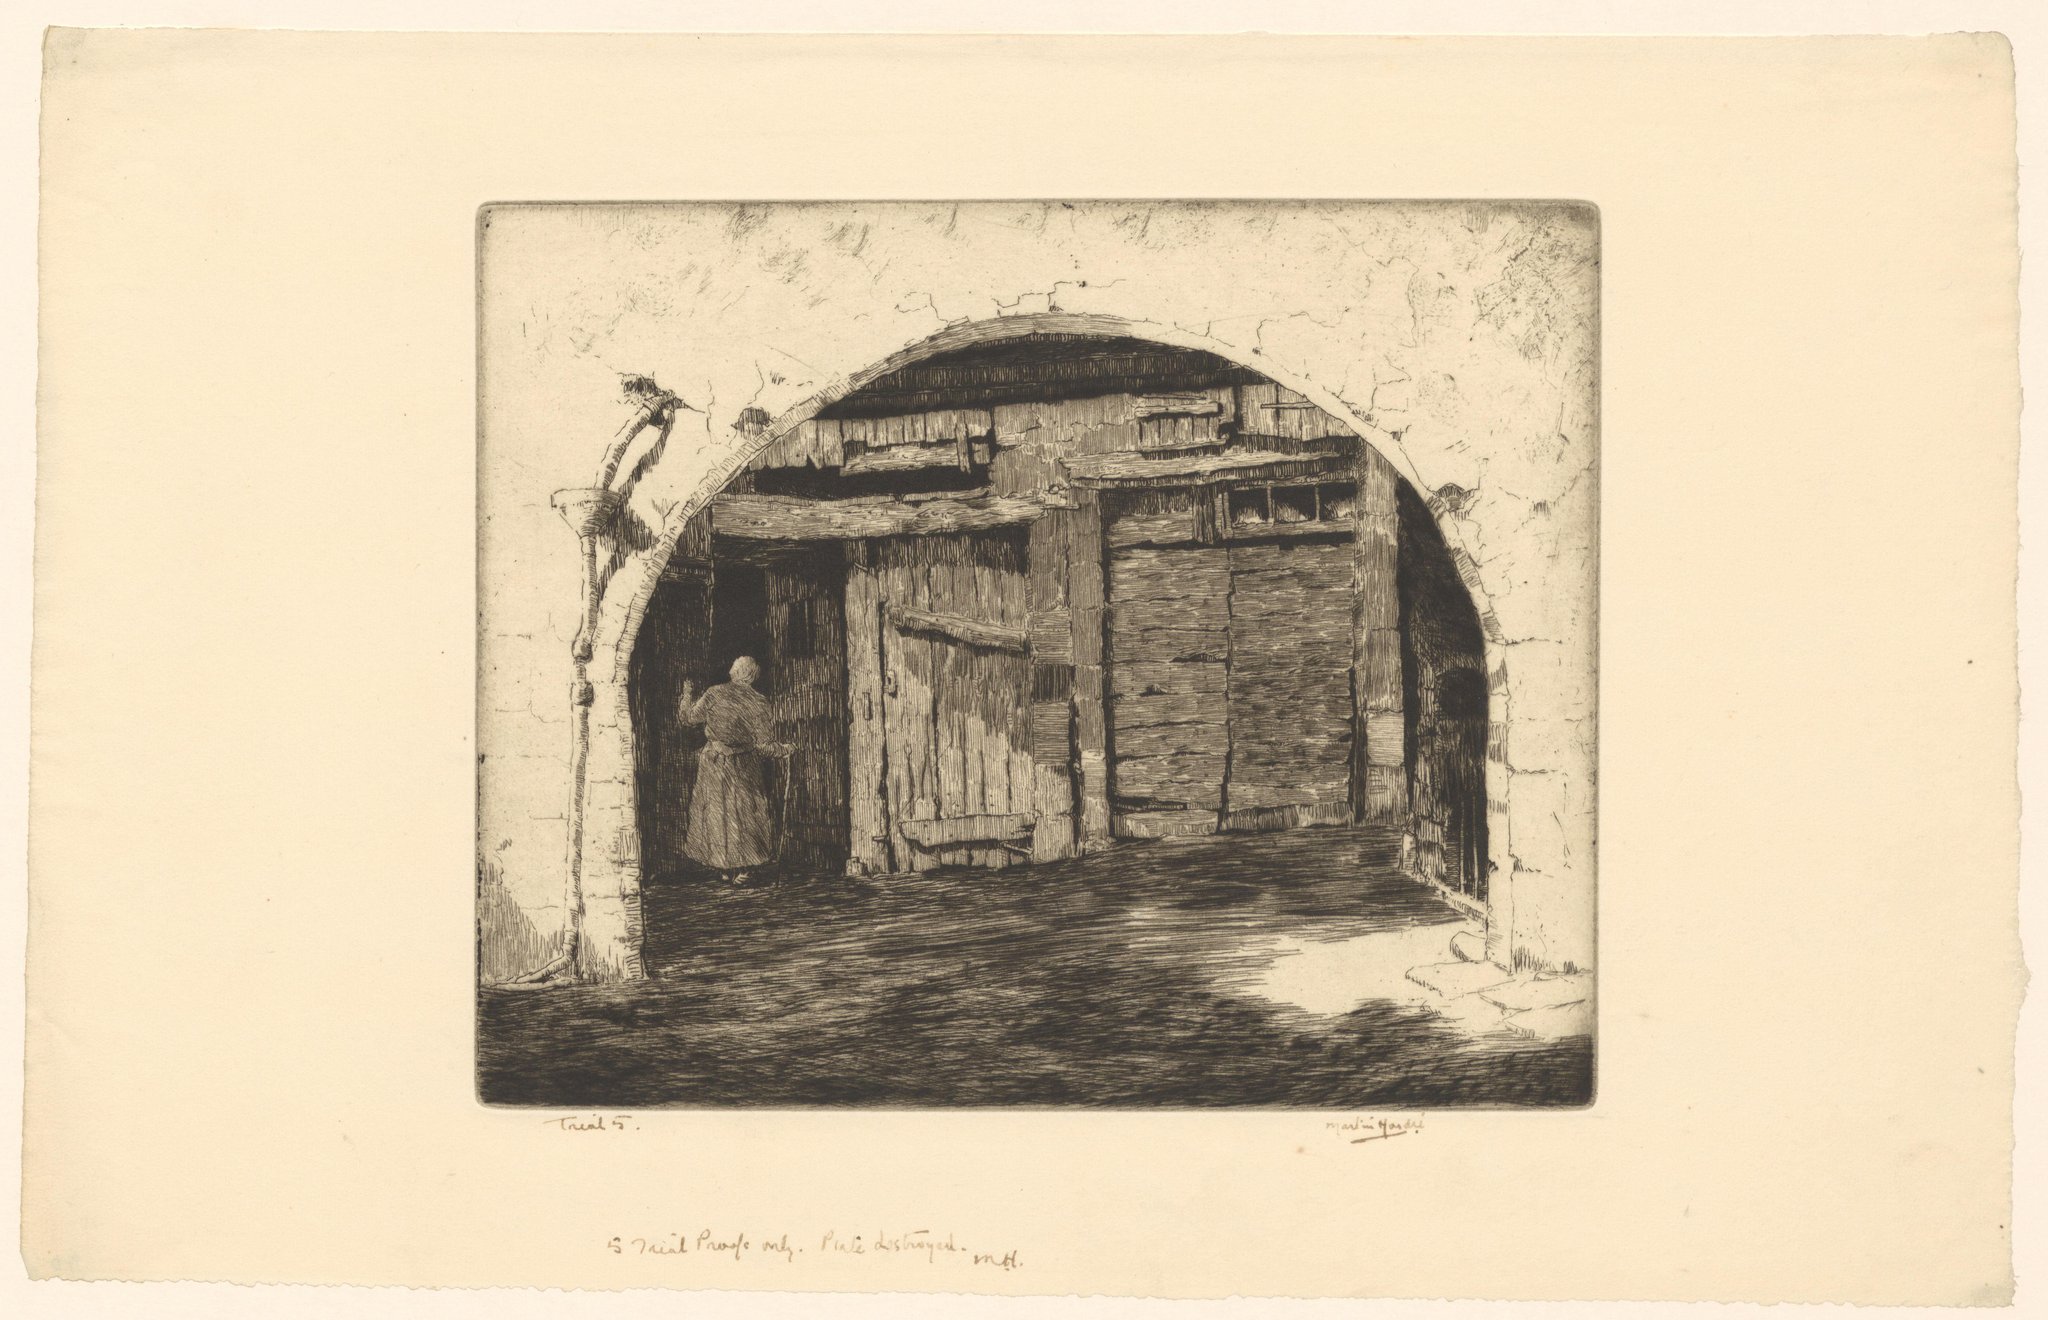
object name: print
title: L'Aveugle, Mouthier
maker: martin hardie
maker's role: print maker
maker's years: 1875-1952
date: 1930-1931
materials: paper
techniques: drypoint, etching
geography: mouthier-haute-pierre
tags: blind, blindness, gate, entrance, stall, stable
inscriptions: collector's mark: Lugt 2760, annotation: ‘Martin Hardie’, collector's mark: Lugt 2228